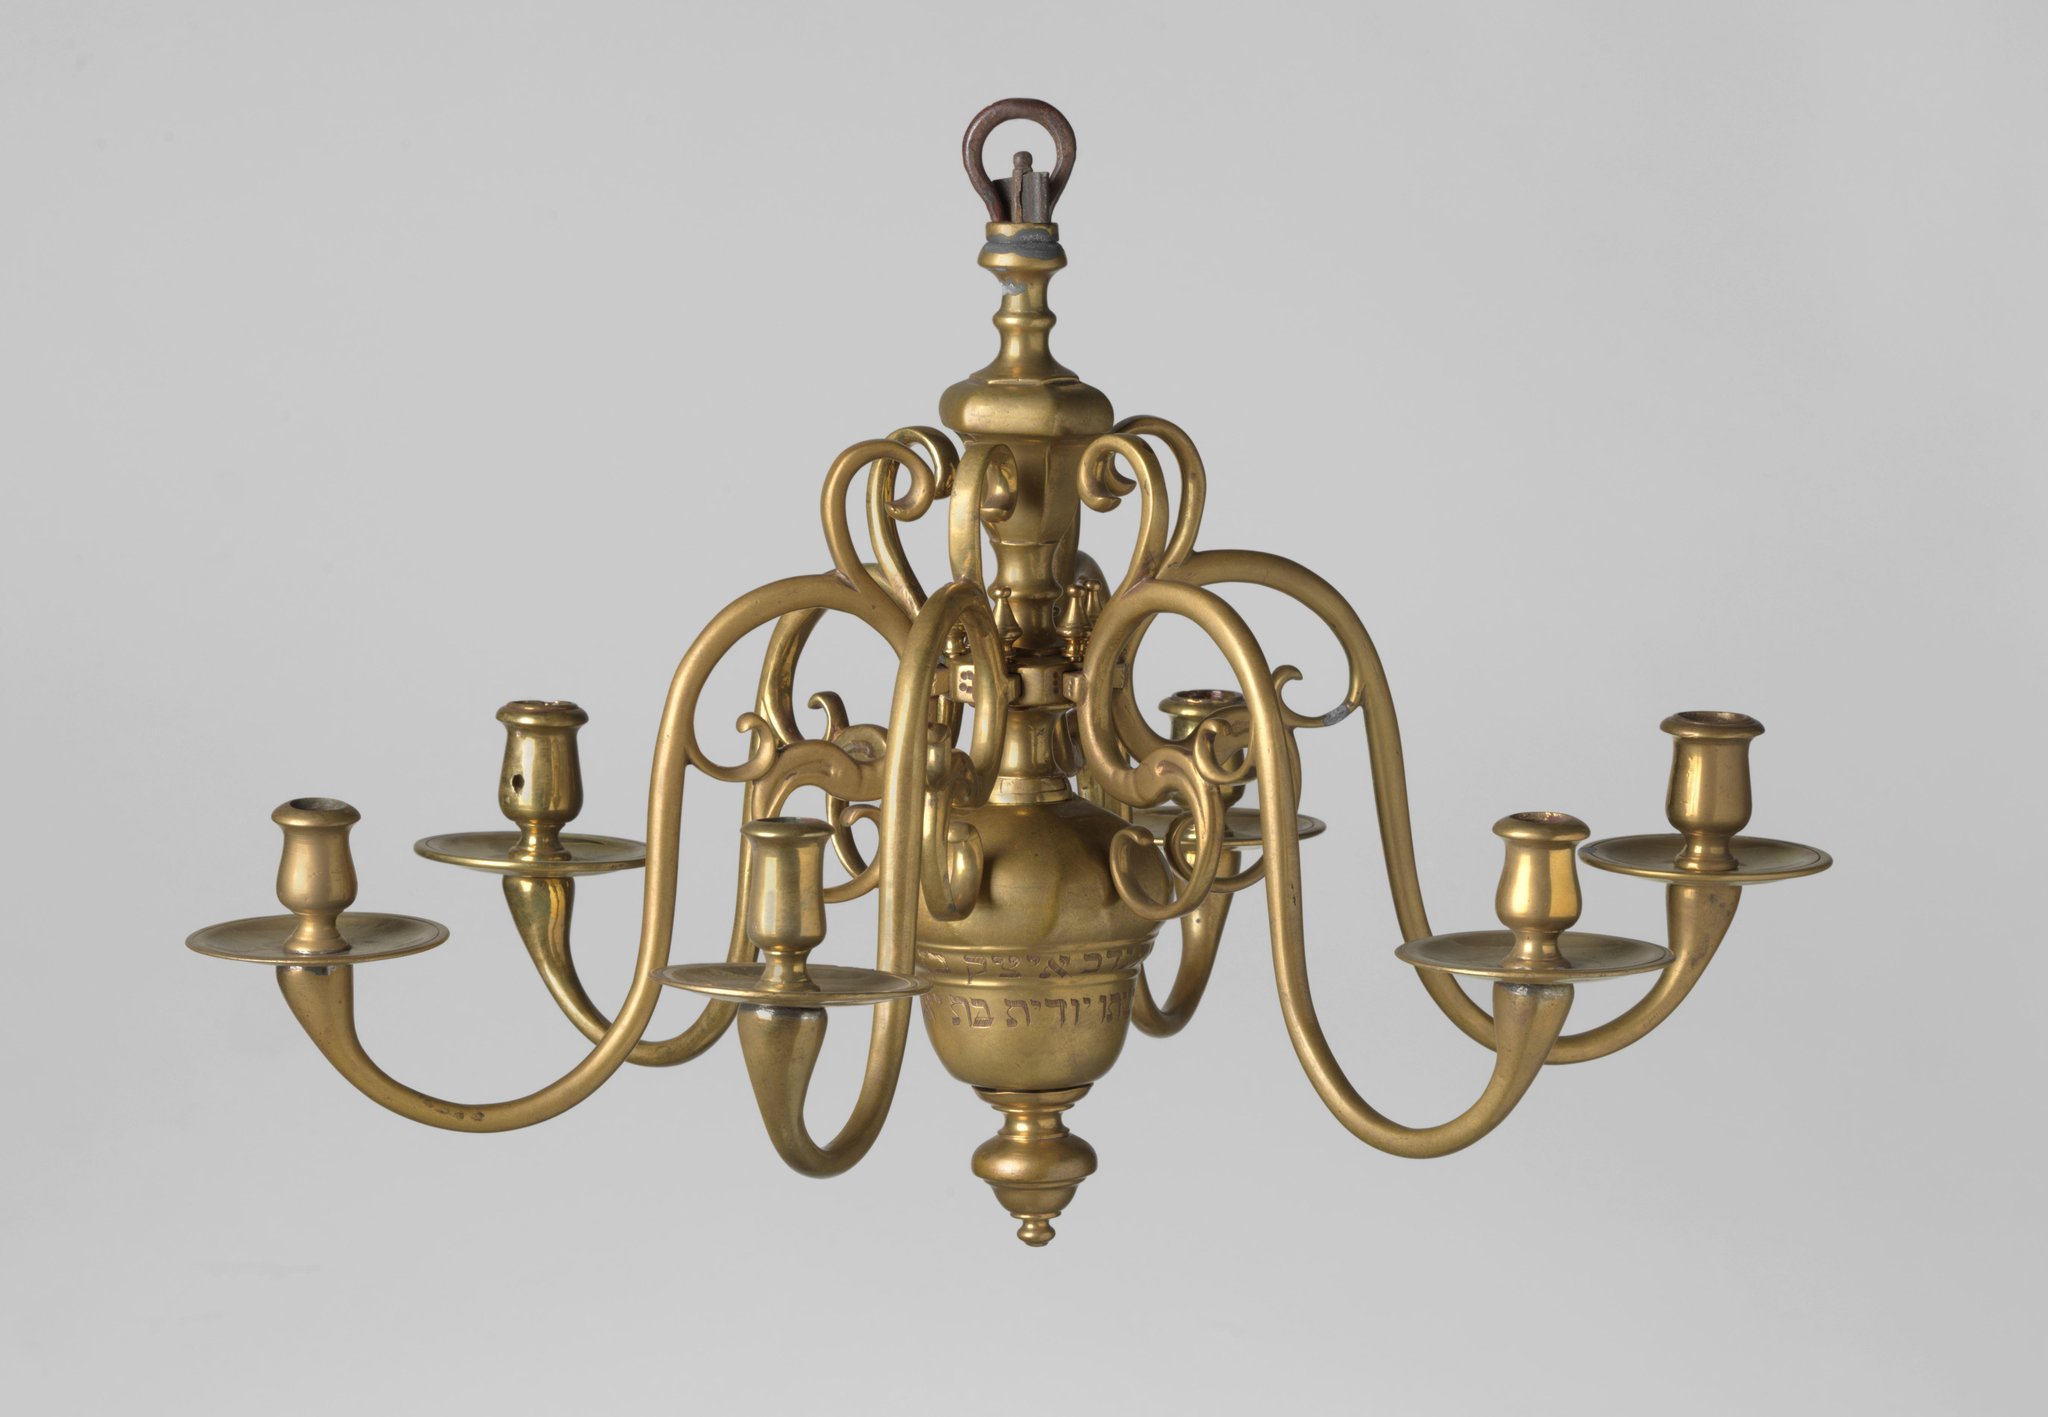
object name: chandelier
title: Stam van kaarsenkroon met zes armen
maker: Anonymous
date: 1795-1800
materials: brass, iron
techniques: casting, engraving, forging, turning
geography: amsterdam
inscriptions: inscription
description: Het voorwerp bestaat uit een ronde smeedijzeren stang, een hangring met smeedijzeren oog, een splitpen van koperplaat, en de volgende gegoten en op de draaibank bewerkte delen van geel koper: het stamdeel met de standring, de bol, de knop. Het stamdeel heeft de vorm van een zesvlakkige baluster of vaas met daaronder de standring, waarvan de openingen met één t/m zes punten zijn gemerkt. De eikelvormige bol heeft een gegraveerd Hebreeuws opschrift. De geprofileerde knop eindigt in een klein knopje en is bevestigd aan de stang met bovenaan het oog voor de splitpen.